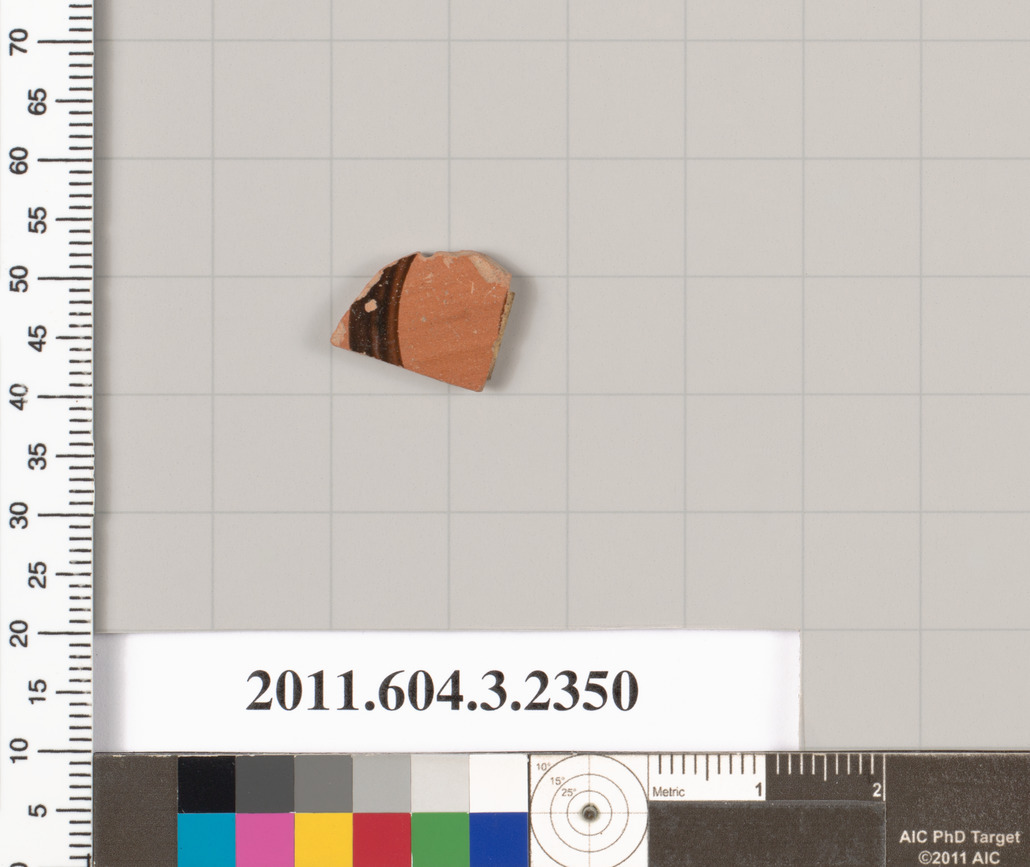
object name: kylix fragment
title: Terracotta fragment of a kylix: eye-cup (drinking cup)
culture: greek, attic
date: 540-520 BCE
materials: terracotta